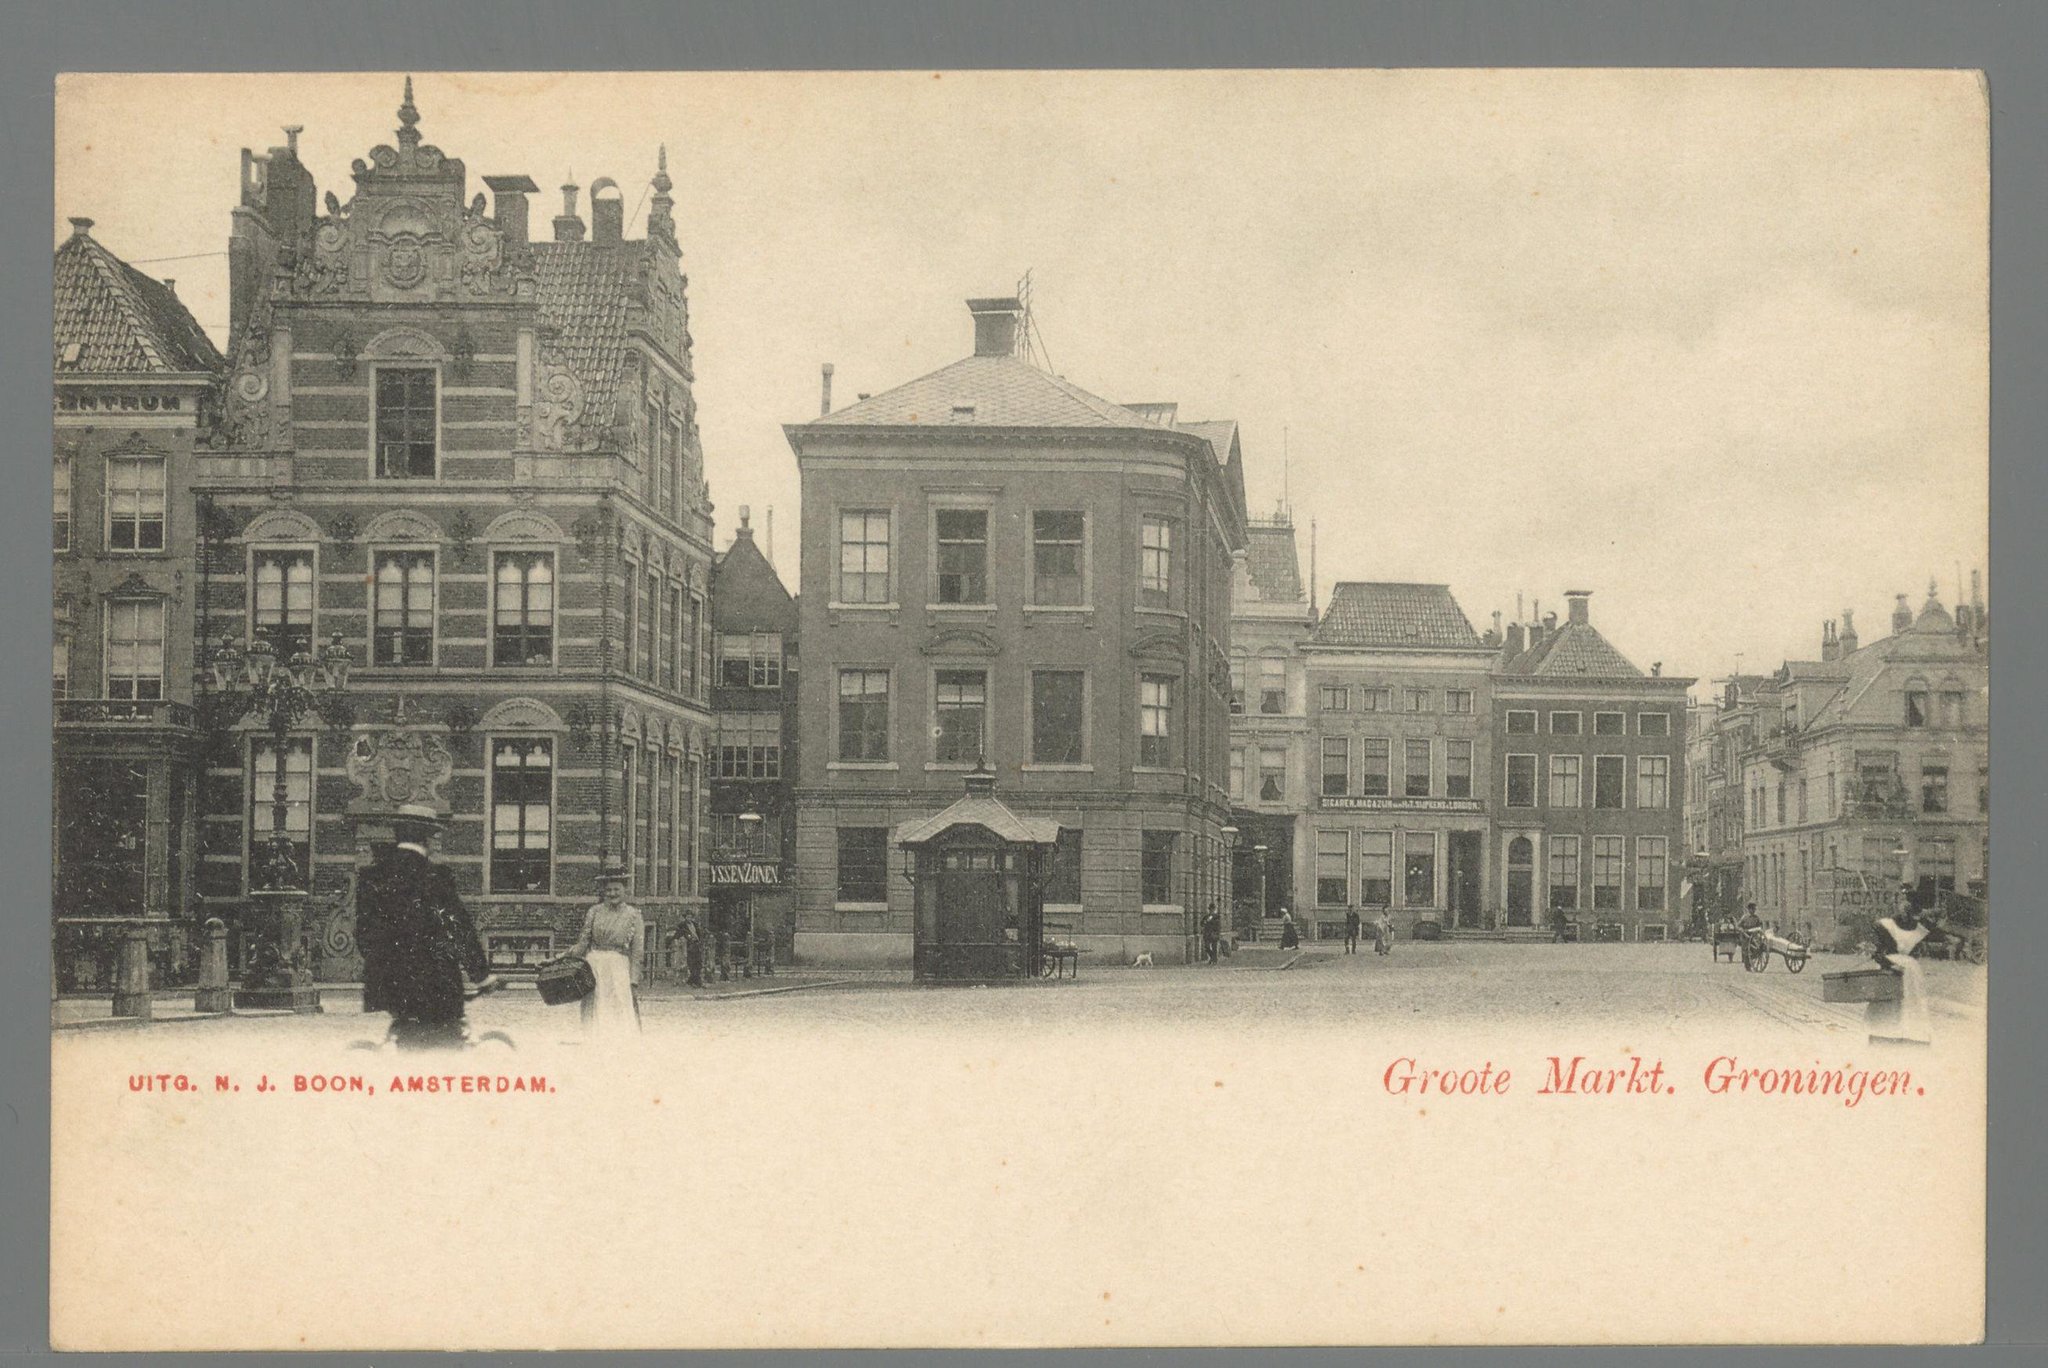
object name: ansichtkaart, prentbriefkaart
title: Groote Markt. Groningen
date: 1897-1905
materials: cardboard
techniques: photograph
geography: amsterdam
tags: square, place, circus, etc.